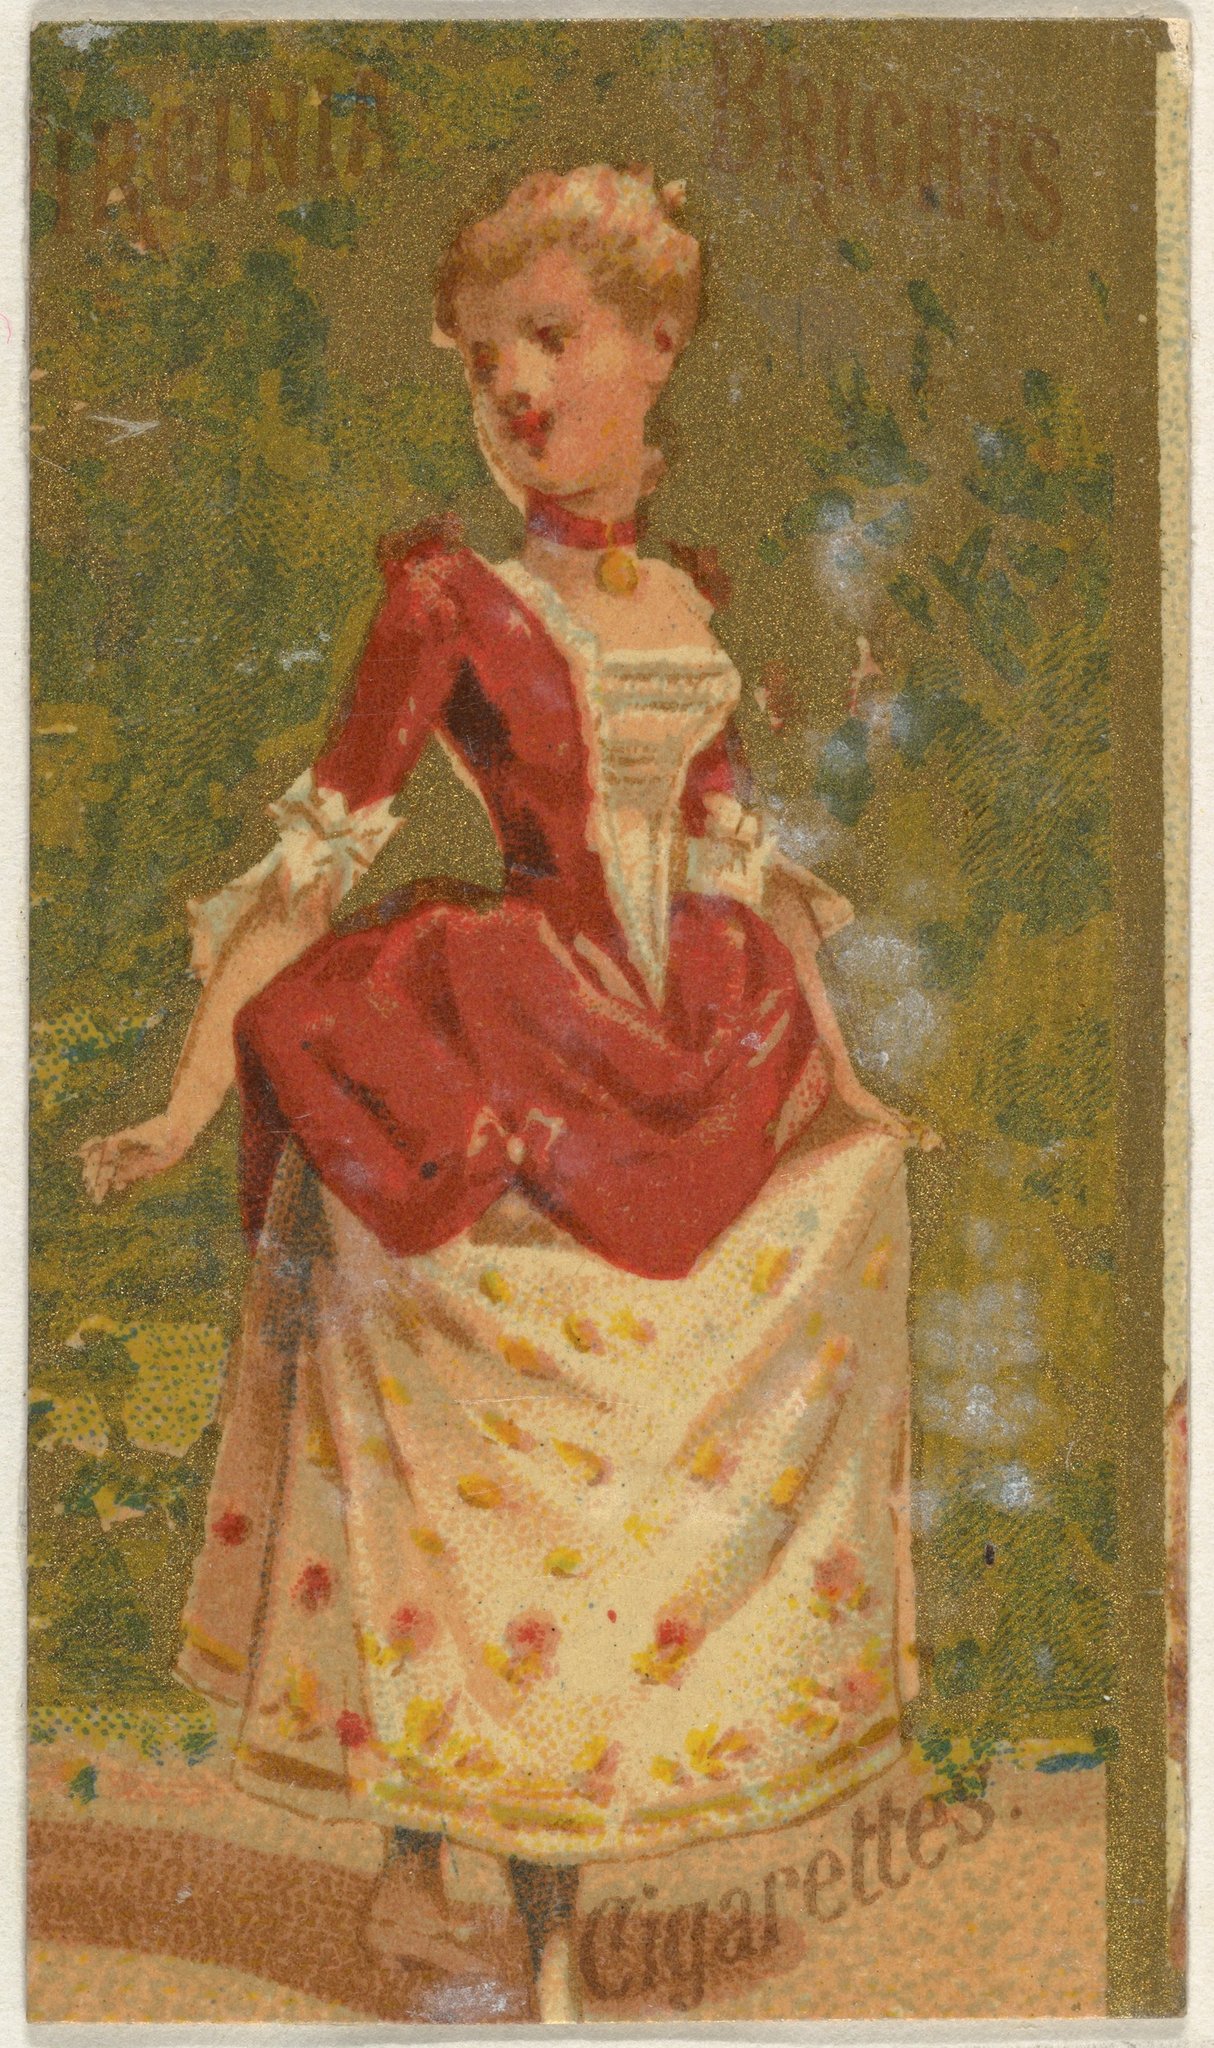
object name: print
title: From the Girls and Children series (N64) promoting Virginia Brights Cigarettes for Allen & Ginter brand tobacco products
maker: allen & ginter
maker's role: publisher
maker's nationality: american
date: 1886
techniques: color lithograph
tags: girls